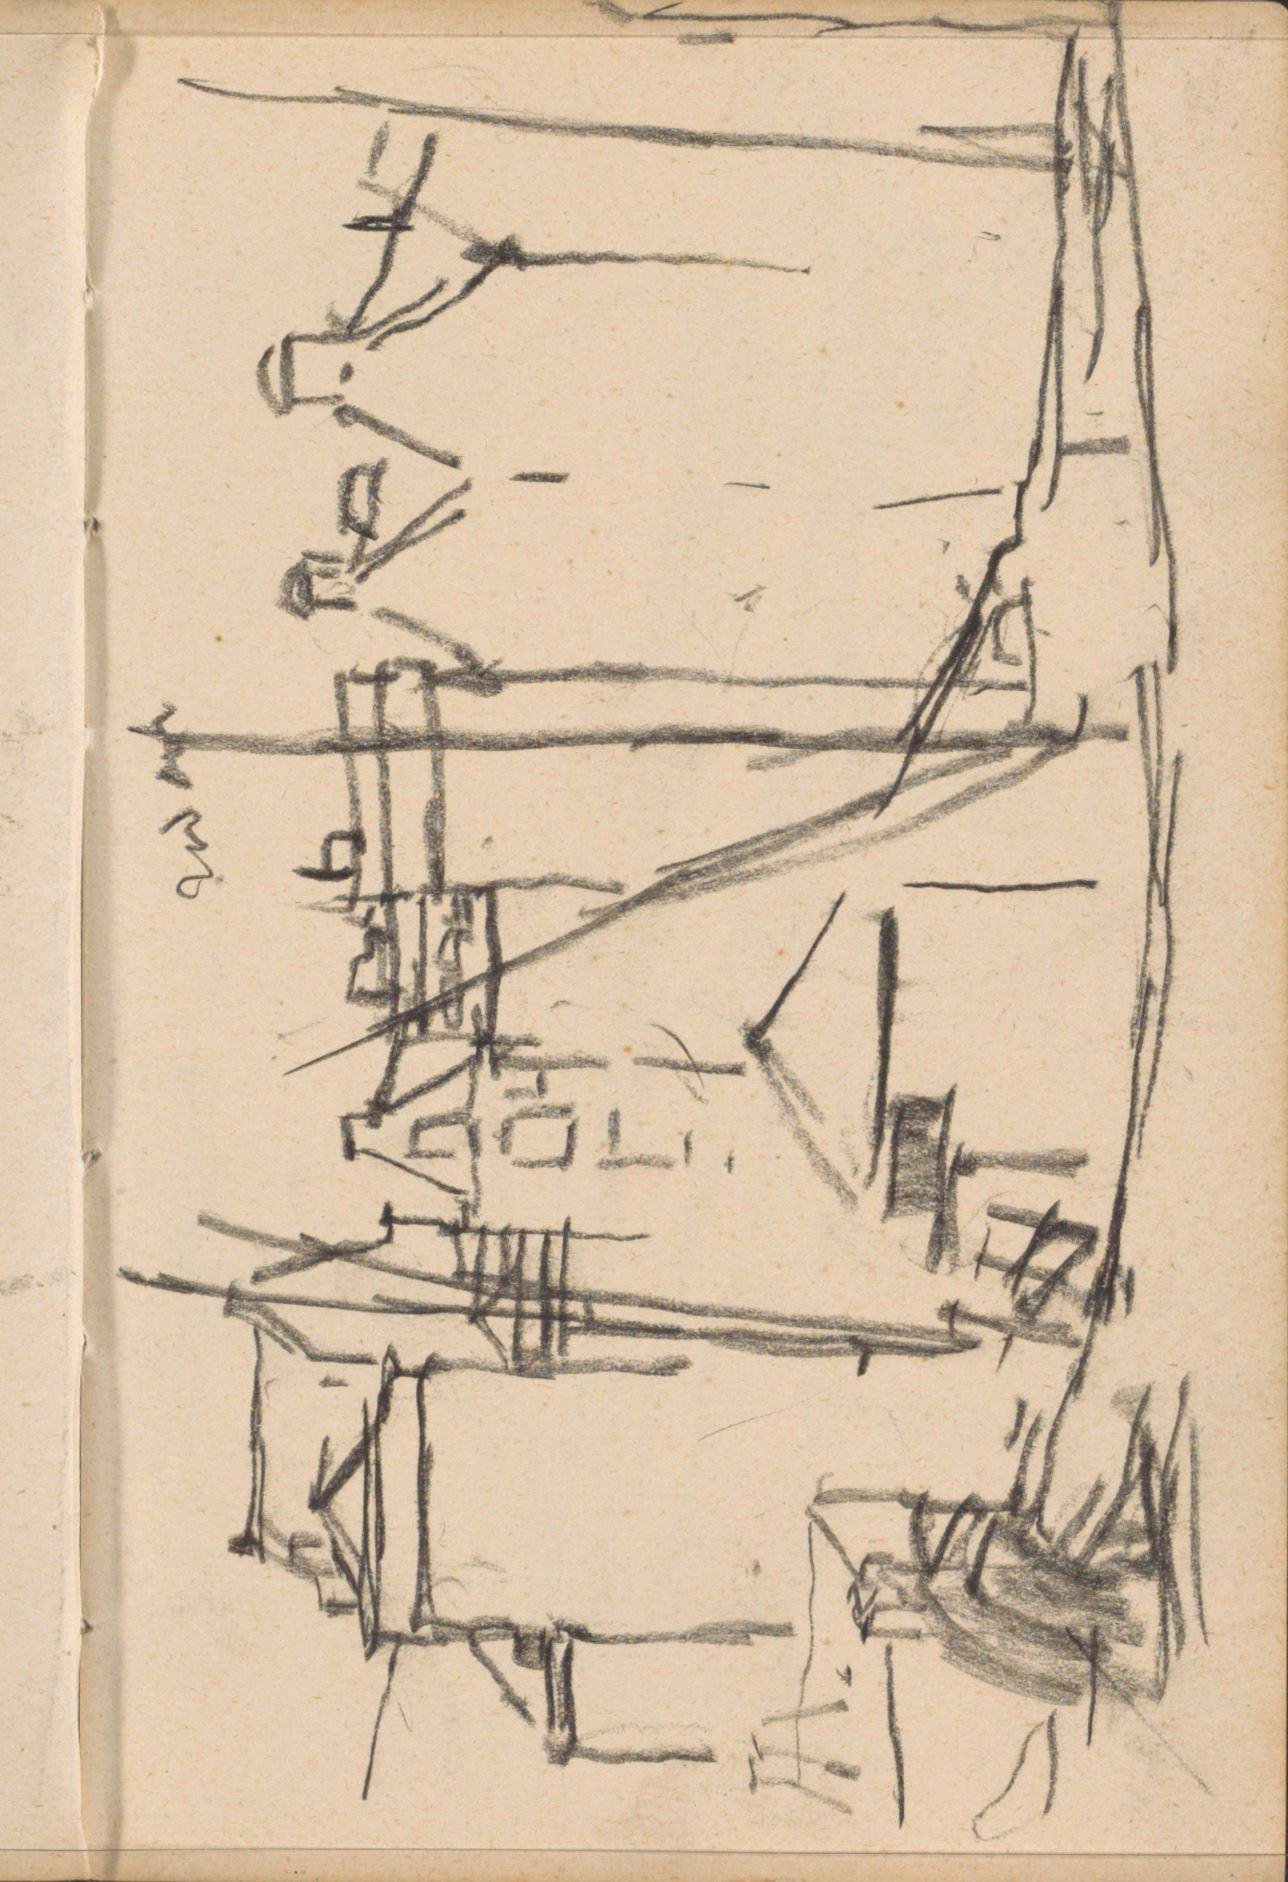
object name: sketchbook leaf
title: Gezicht op het Damrak te Amsterdam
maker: george hendrik breitner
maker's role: draughtsman, painter, print maker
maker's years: 1857-1923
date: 1909-1912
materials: chalk, paper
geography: amsterdam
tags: urban housing, canals, waters (in city)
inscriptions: kleurnotitie, handgeschreven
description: Gezicht op het Damrak te Amsterdam met de achterzijde van de panden aan de Warmoesstraat 32-48, waaronder Theemagazijn Snel. Pagina 28 uit een schetsboek met 46 bladen vervaardigd te Amsterdam.